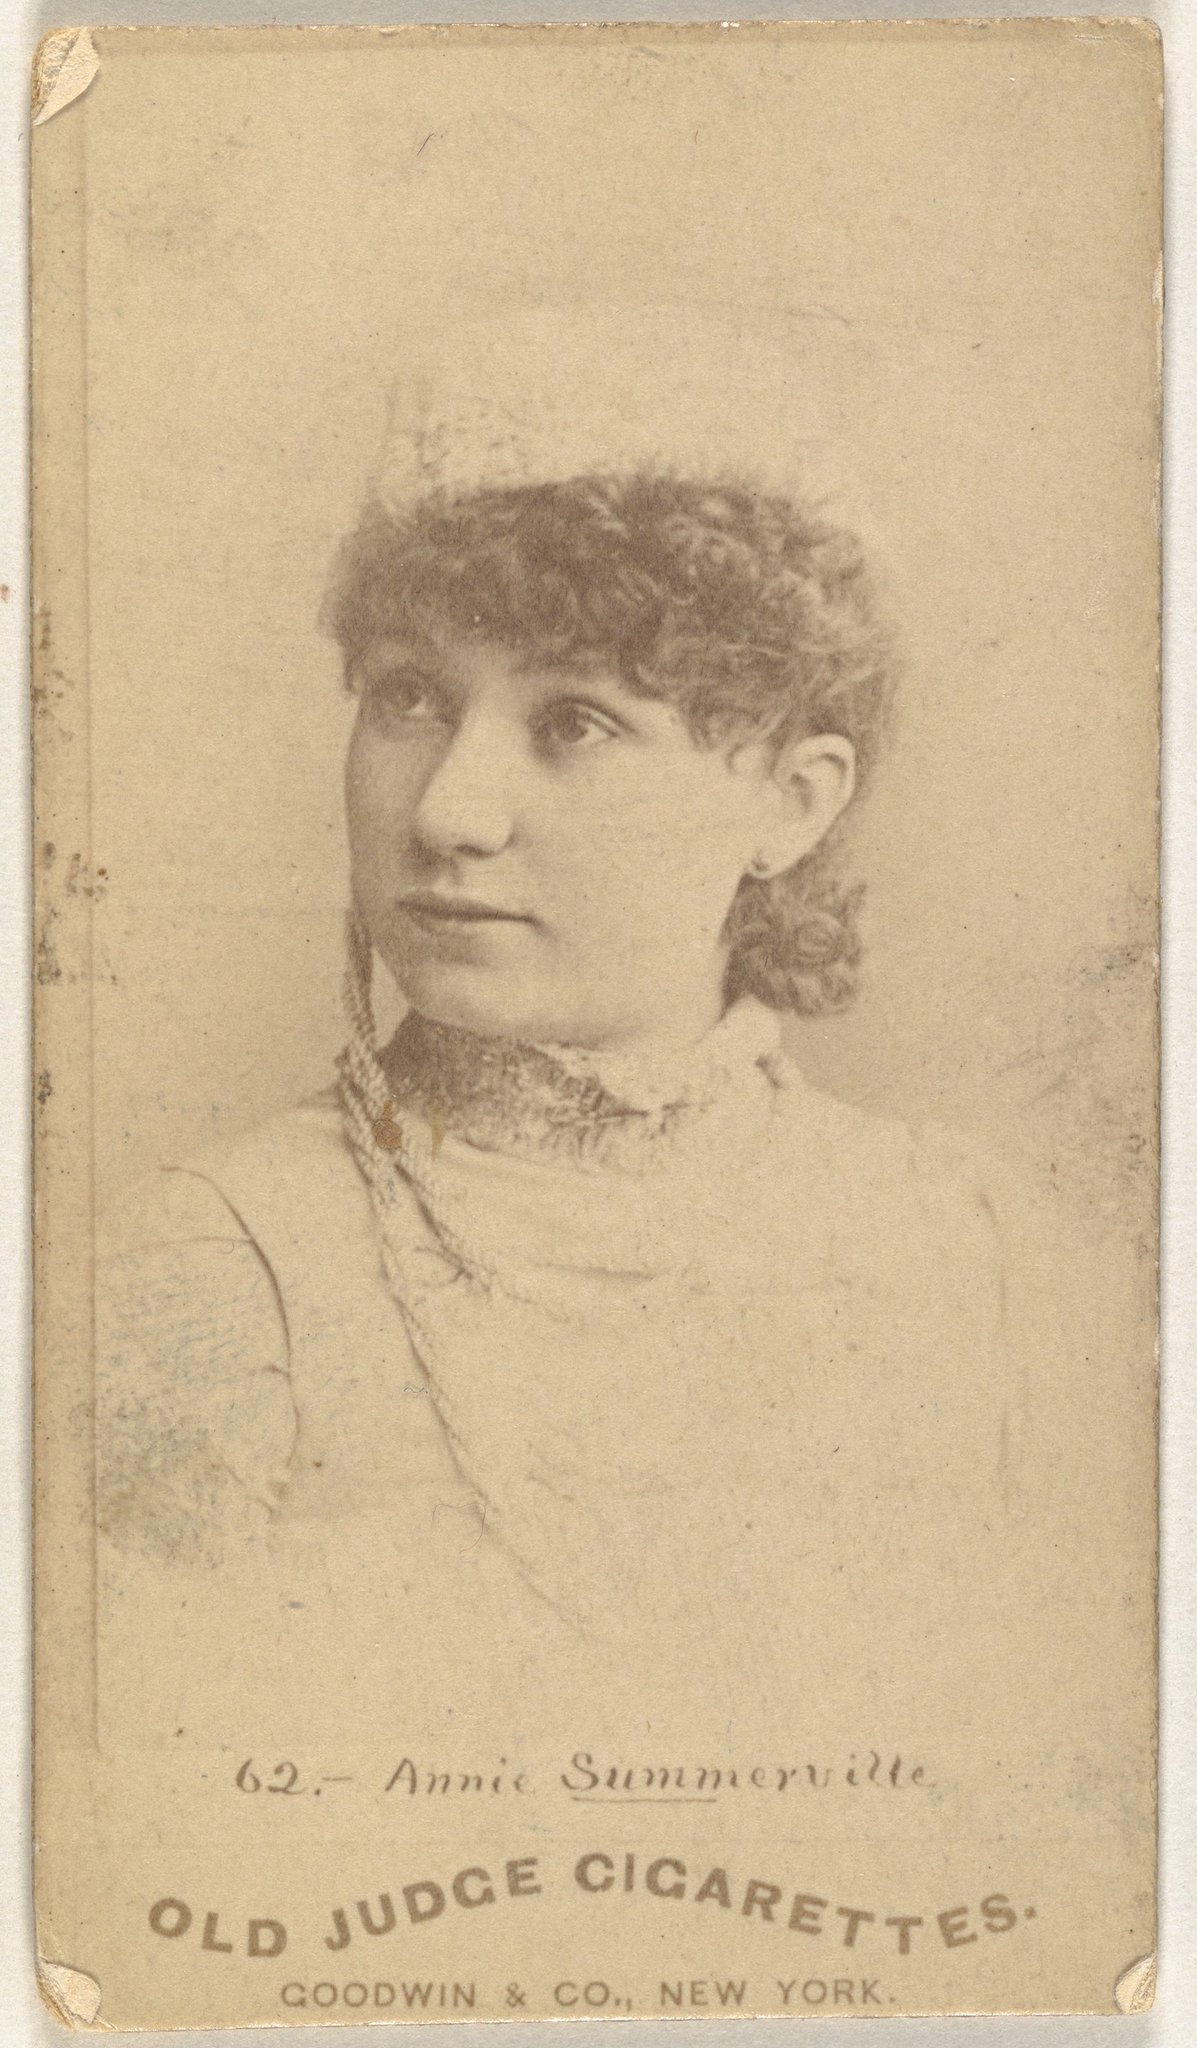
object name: photograph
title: Annie Summerville, from the Actors and Actresses series (N171) for Old Judge Cigarettes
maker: goodwin & company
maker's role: publisher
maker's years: 1850-1950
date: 1886-1890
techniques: albumen silver print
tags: portraits,women,actresses